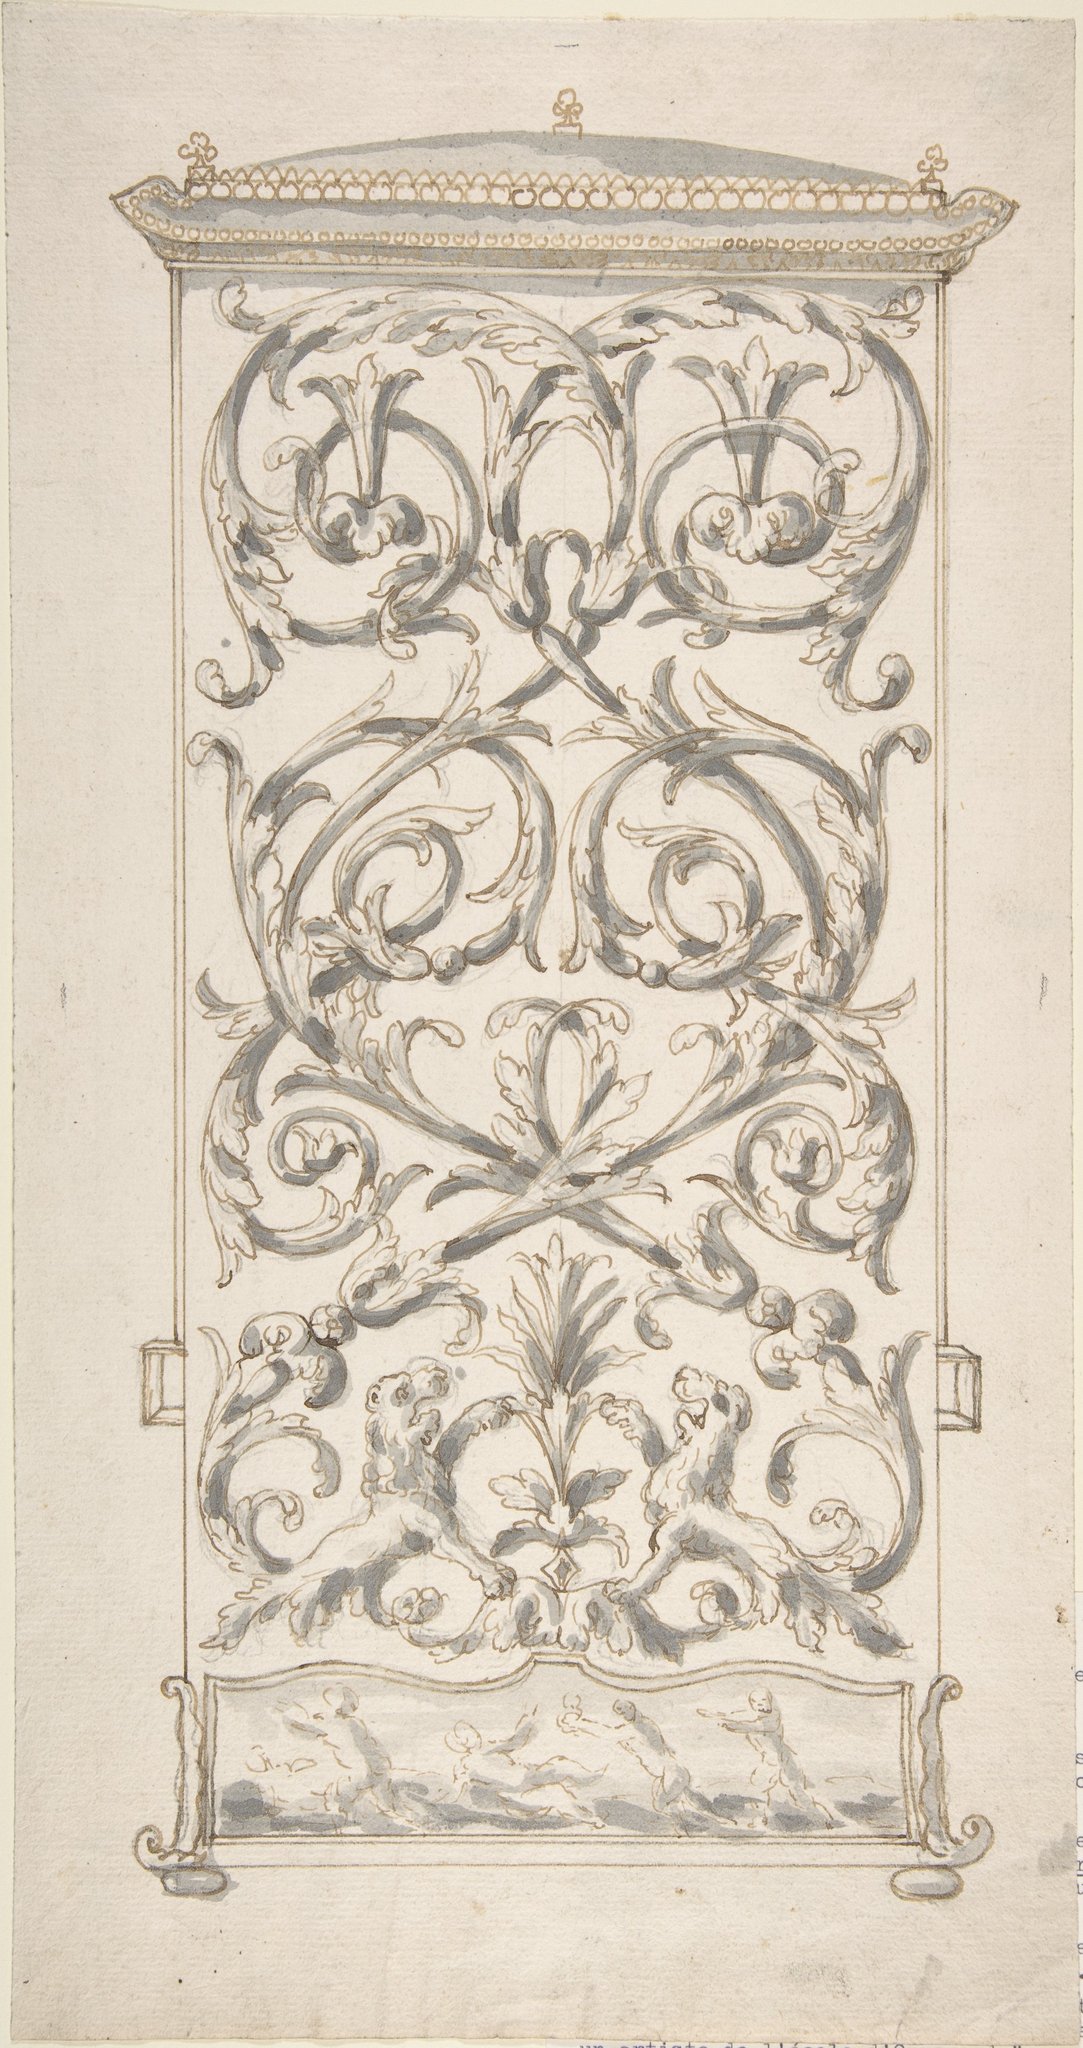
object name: drawing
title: Design for Back of a Sedan Chair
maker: anonymous, french, 18th century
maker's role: artist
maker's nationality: french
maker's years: 1700-1800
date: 1700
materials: graphite, ink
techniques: brush, pen, wash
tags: animals,ornament